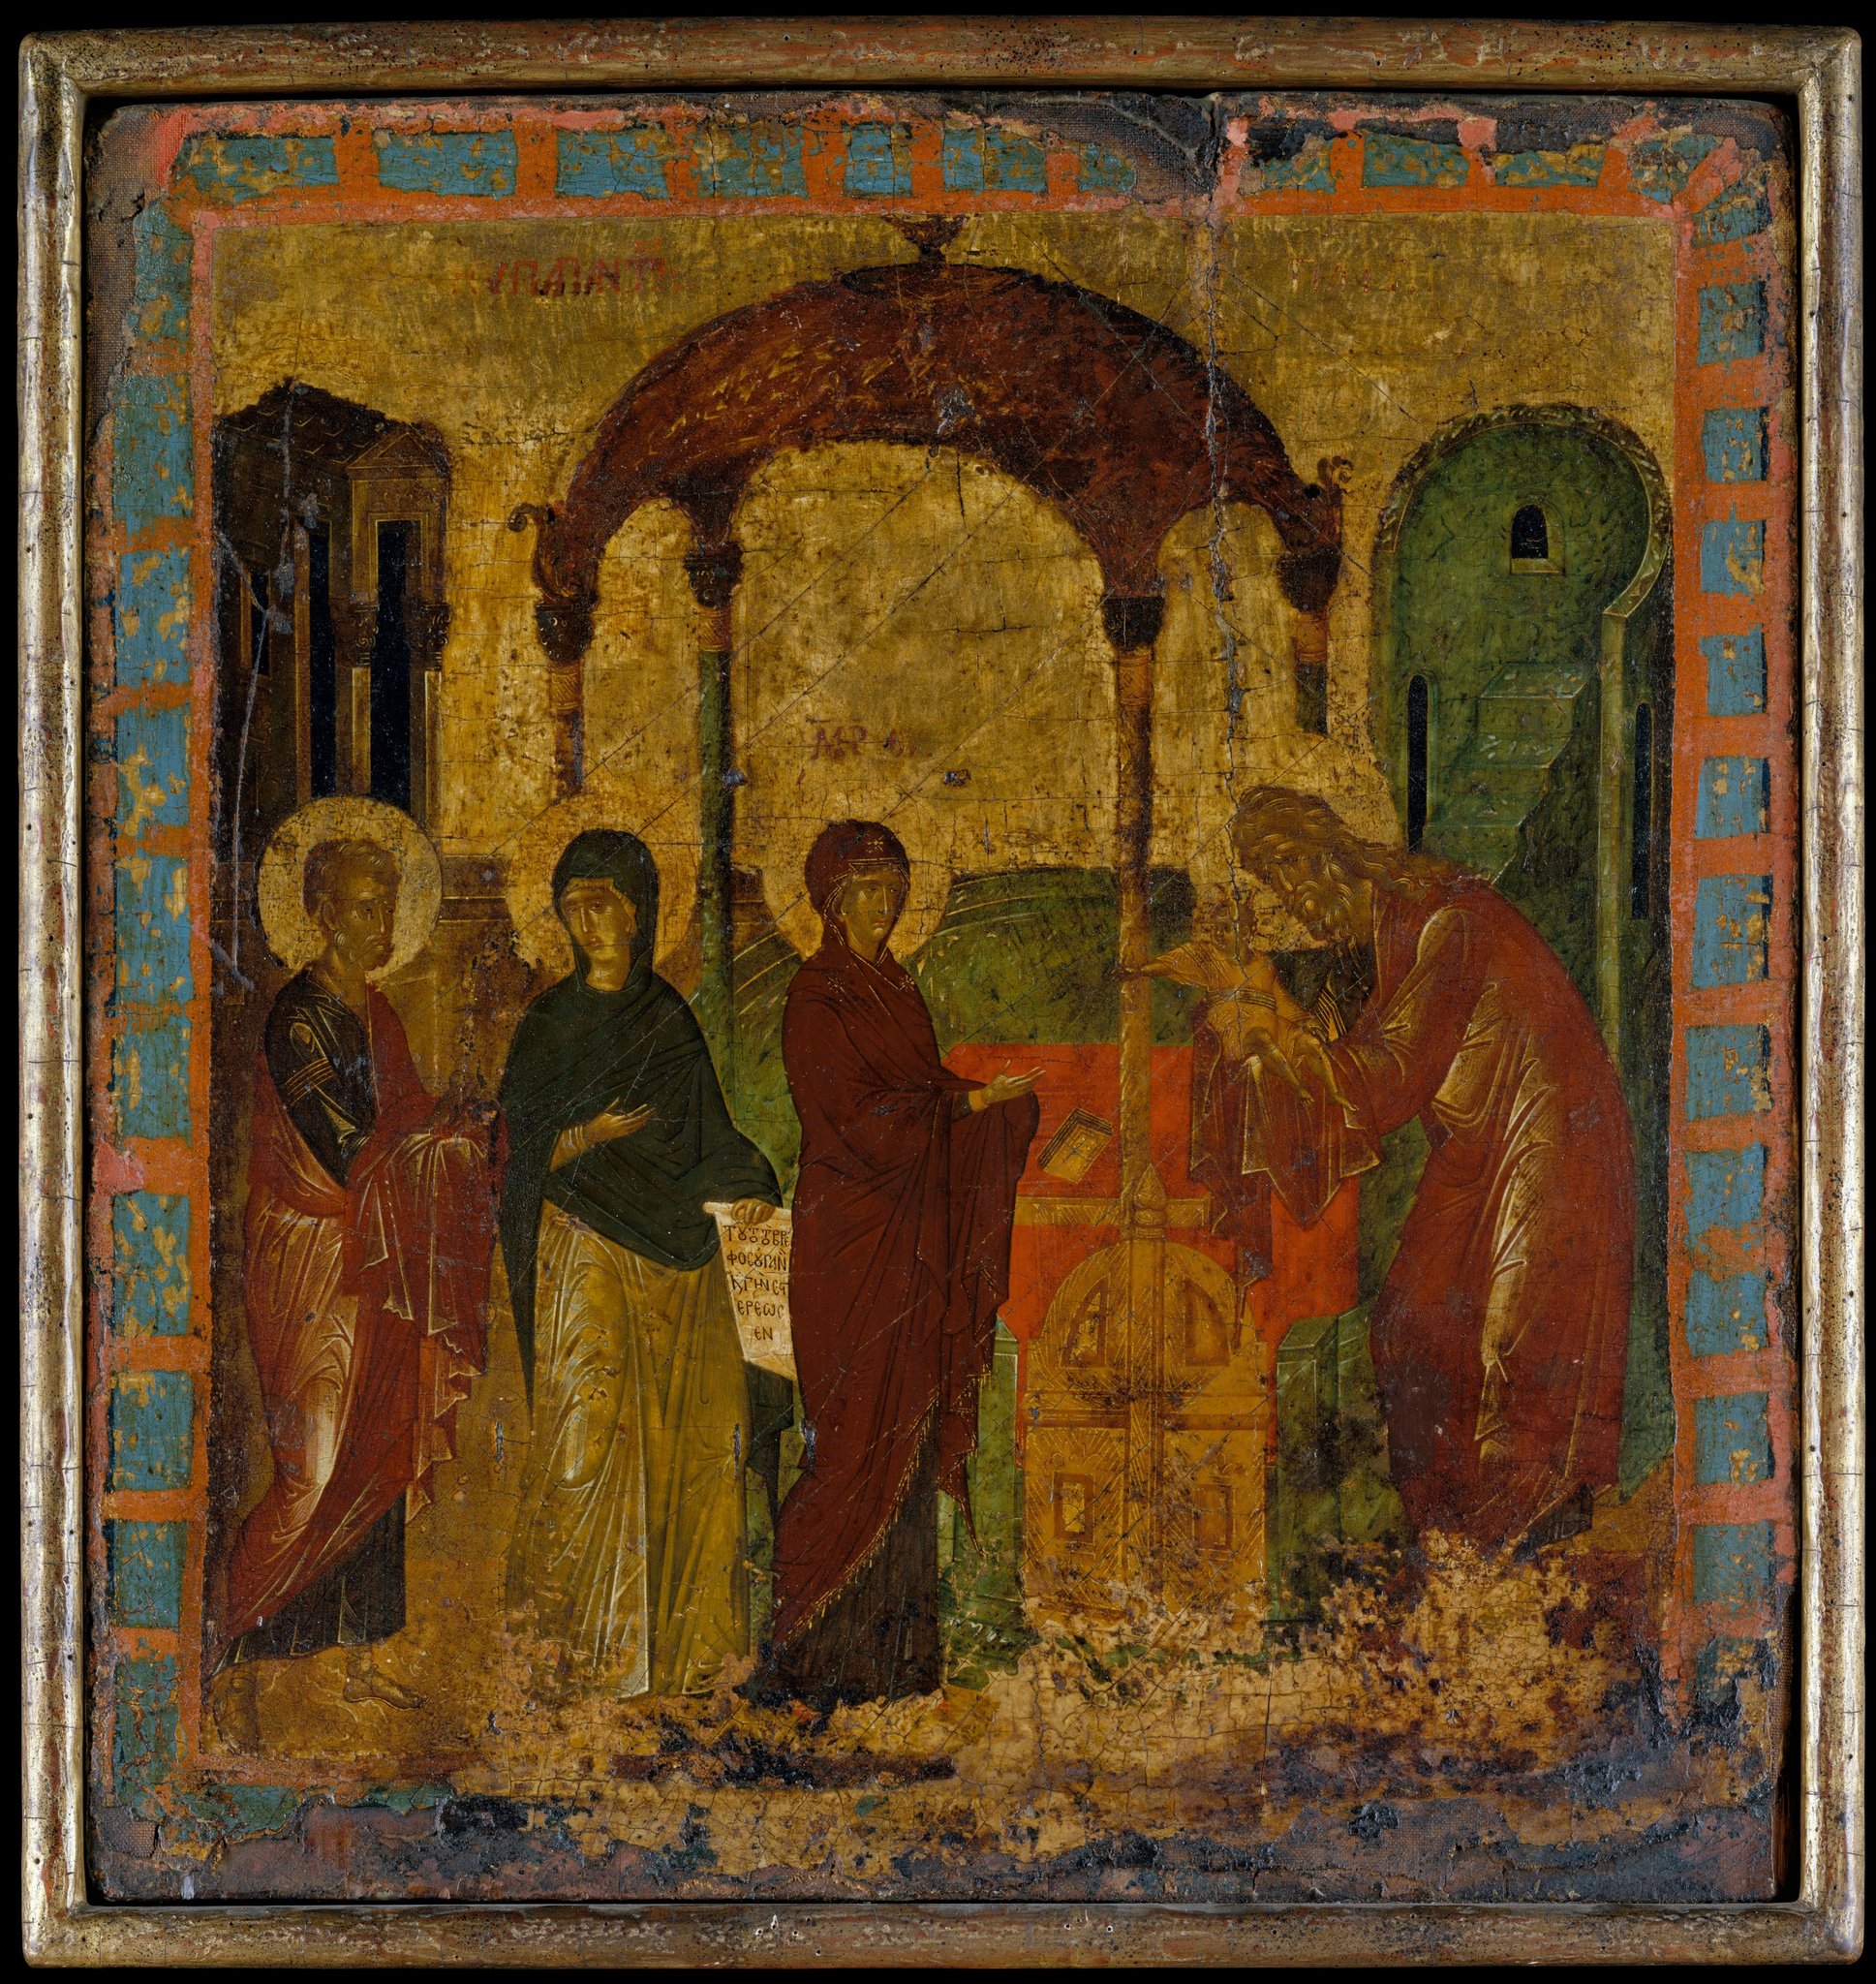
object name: painting, icon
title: The Presentation in the Temple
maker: byzantine painter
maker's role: artist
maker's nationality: byzantine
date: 1400-1499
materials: gold leaf, paint, wood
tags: temples,women,christ,virgin mary,saints